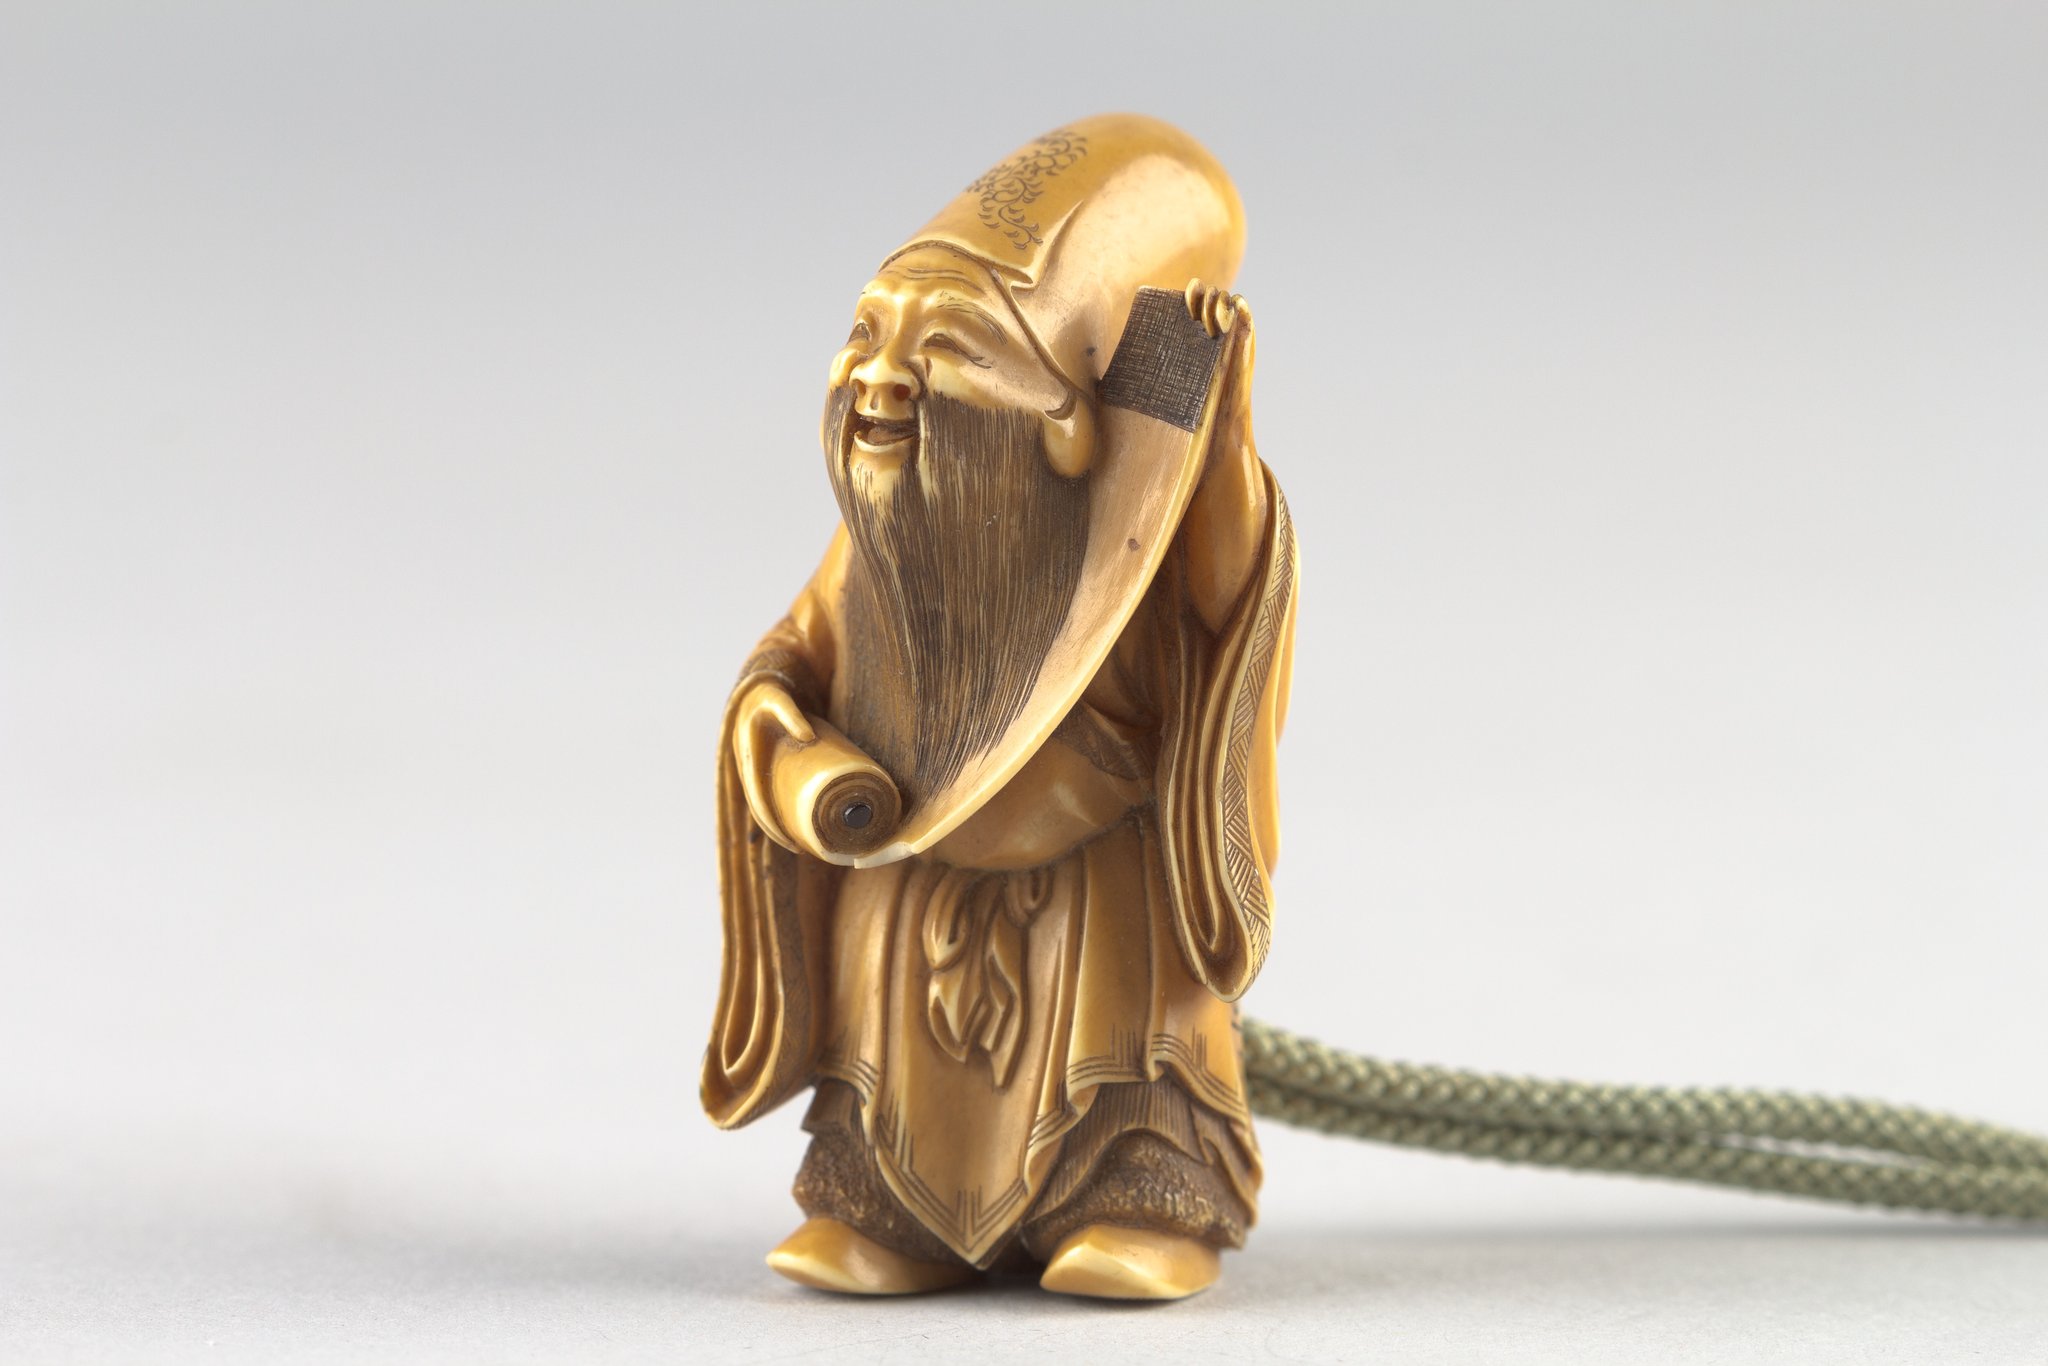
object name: netsuke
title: Netsuke of a Chinese sage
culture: japanese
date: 1701-1800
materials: ivory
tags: men